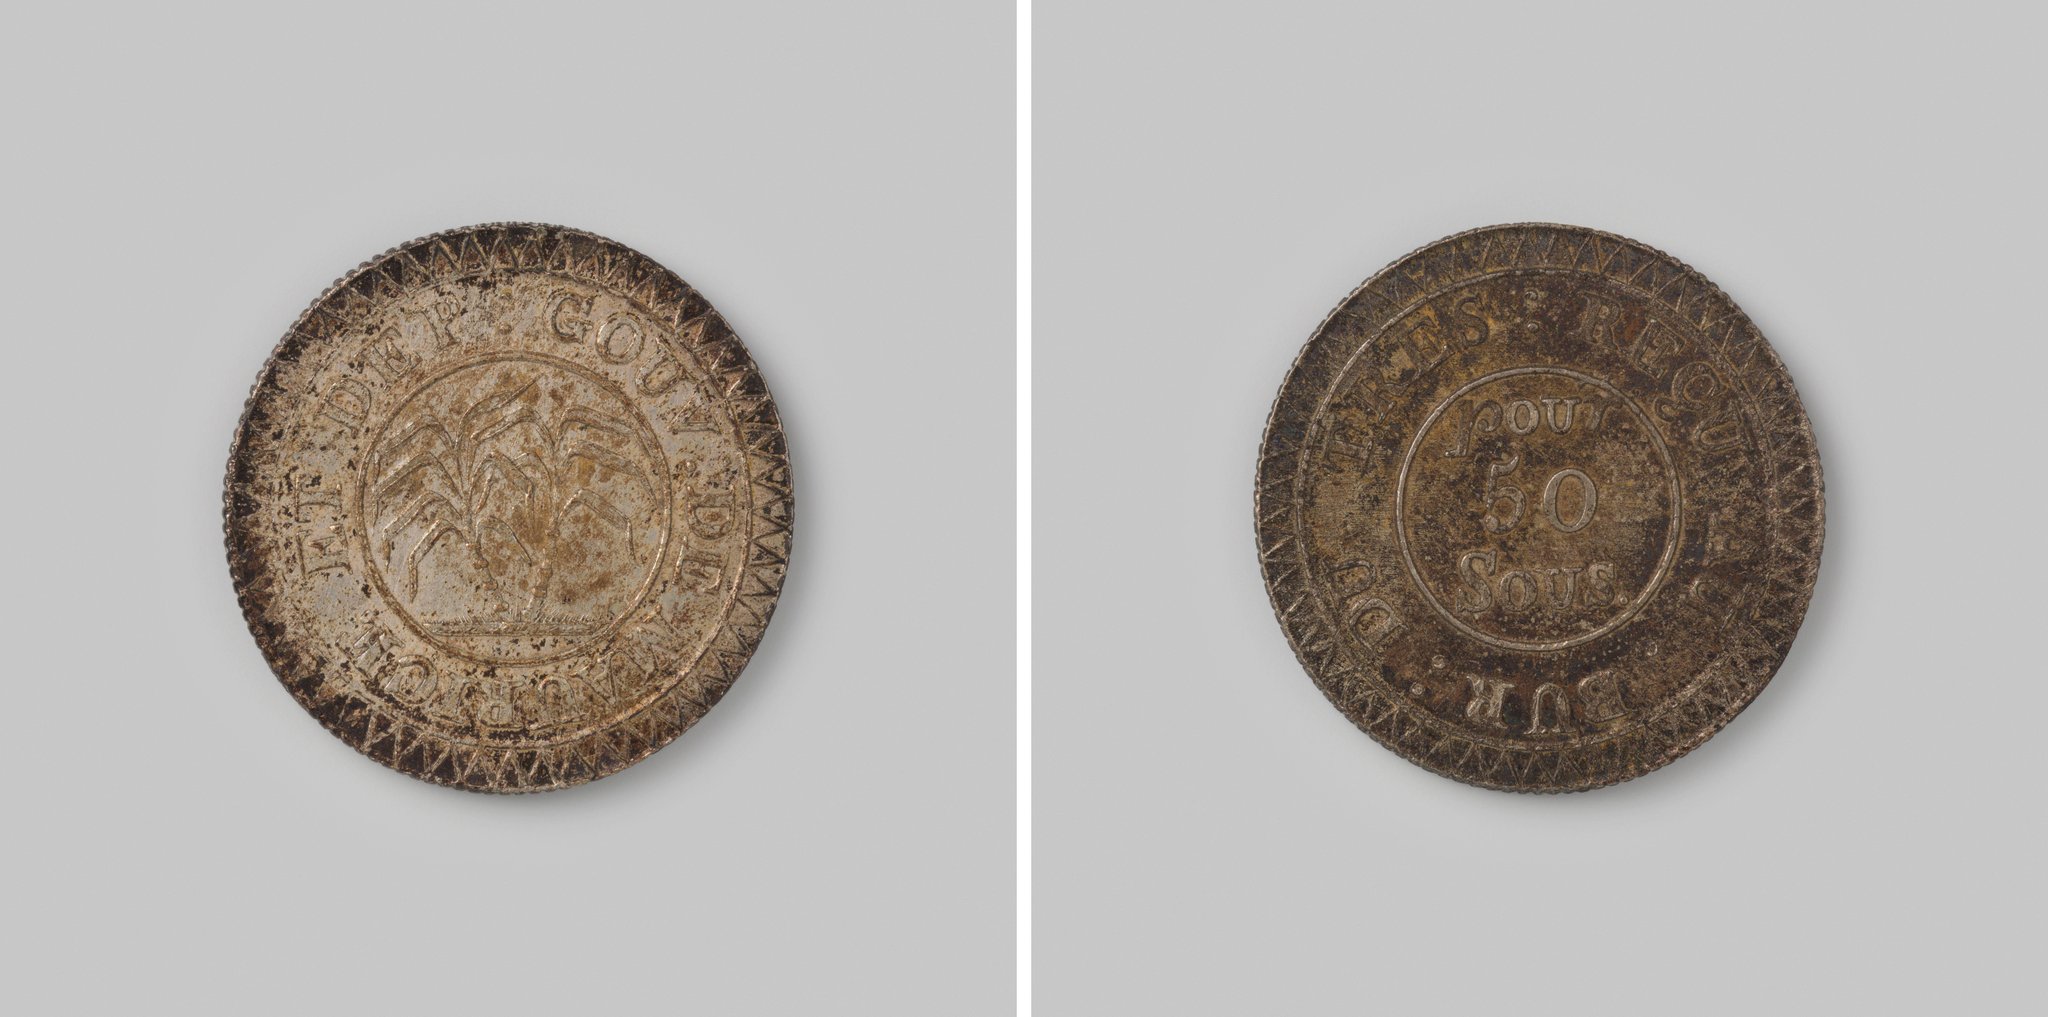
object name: coin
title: 50 sous voor de Britse kolonie Mauritius, [1822]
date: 1822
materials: silver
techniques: striking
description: Zilveren munt. Voorzijde: binnen cirkel bomen. Frans omschrift: GOUV. DE MAURICE ET DEP. Keerzijde: binnen cirkel in drie regels waarde-aanduiding in het Frans: pour 50 sous. Omschrift in het Frans.